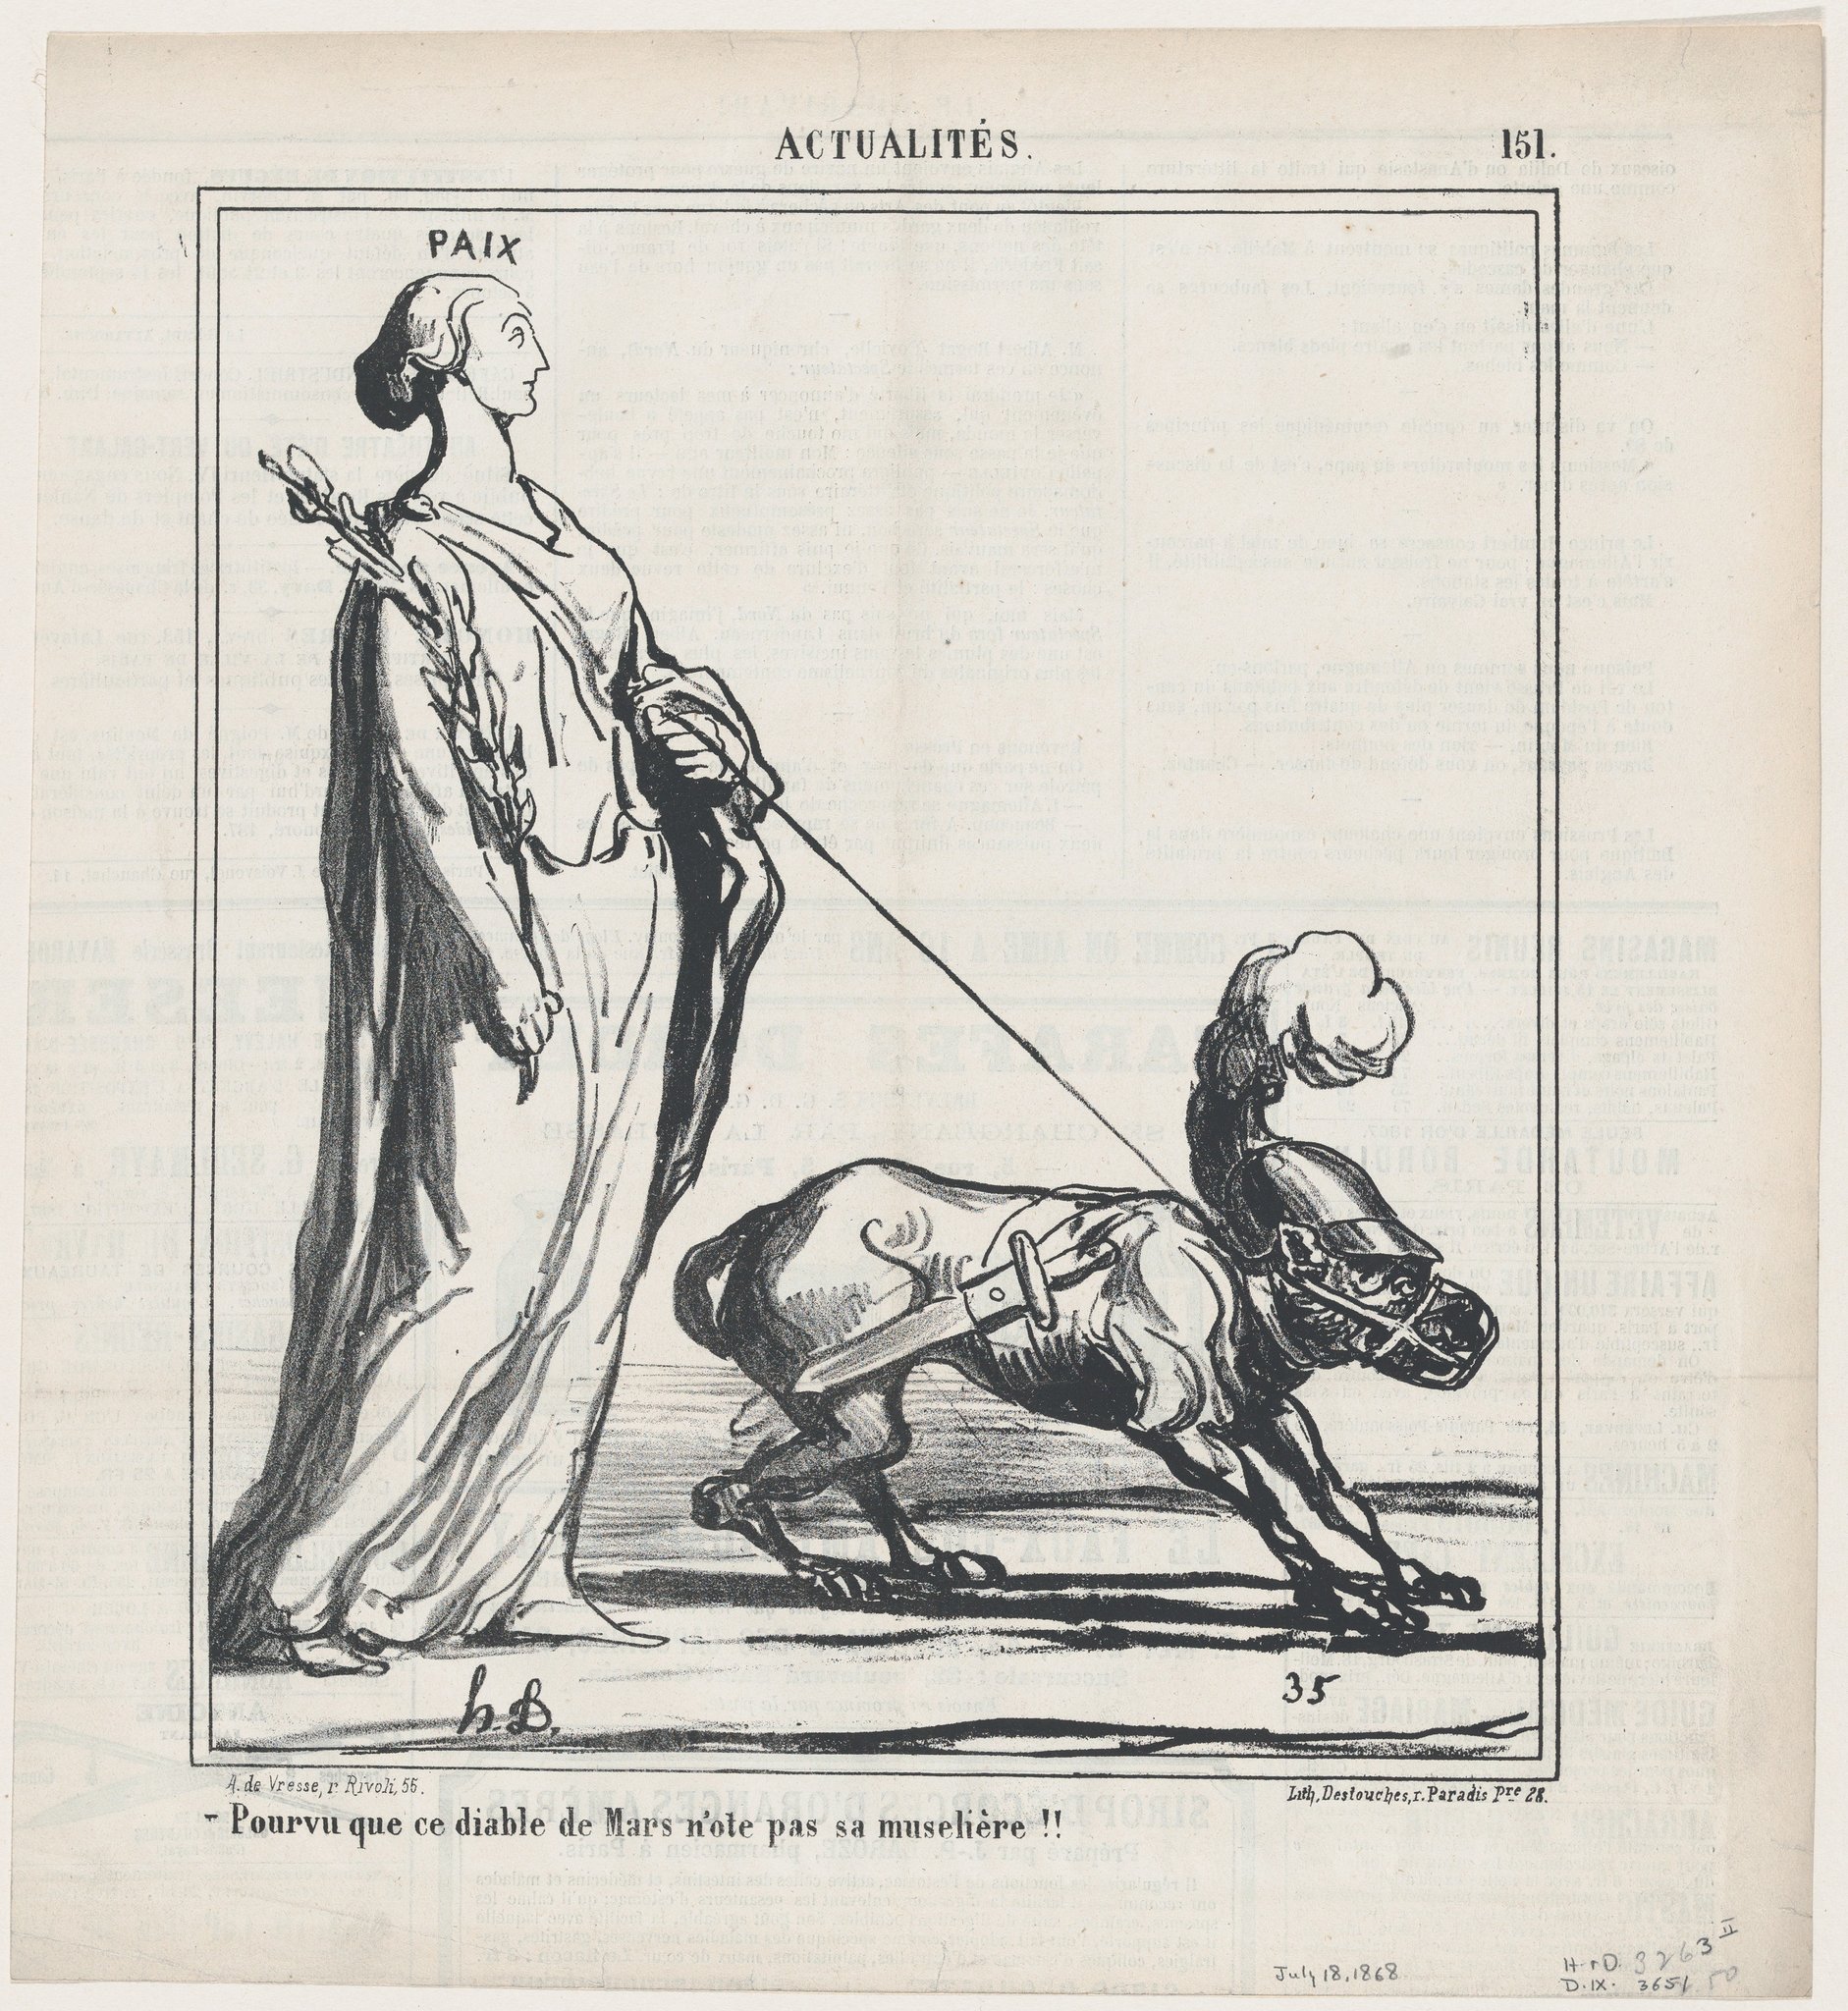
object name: print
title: Let's just hope that this devil Mars doesn't pull out of his muzzle, from "News of the Day"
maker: honoré daumier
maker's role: artist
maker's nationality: french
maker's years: 1808-1879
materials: paper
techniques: lithograph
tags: animals,satire,women